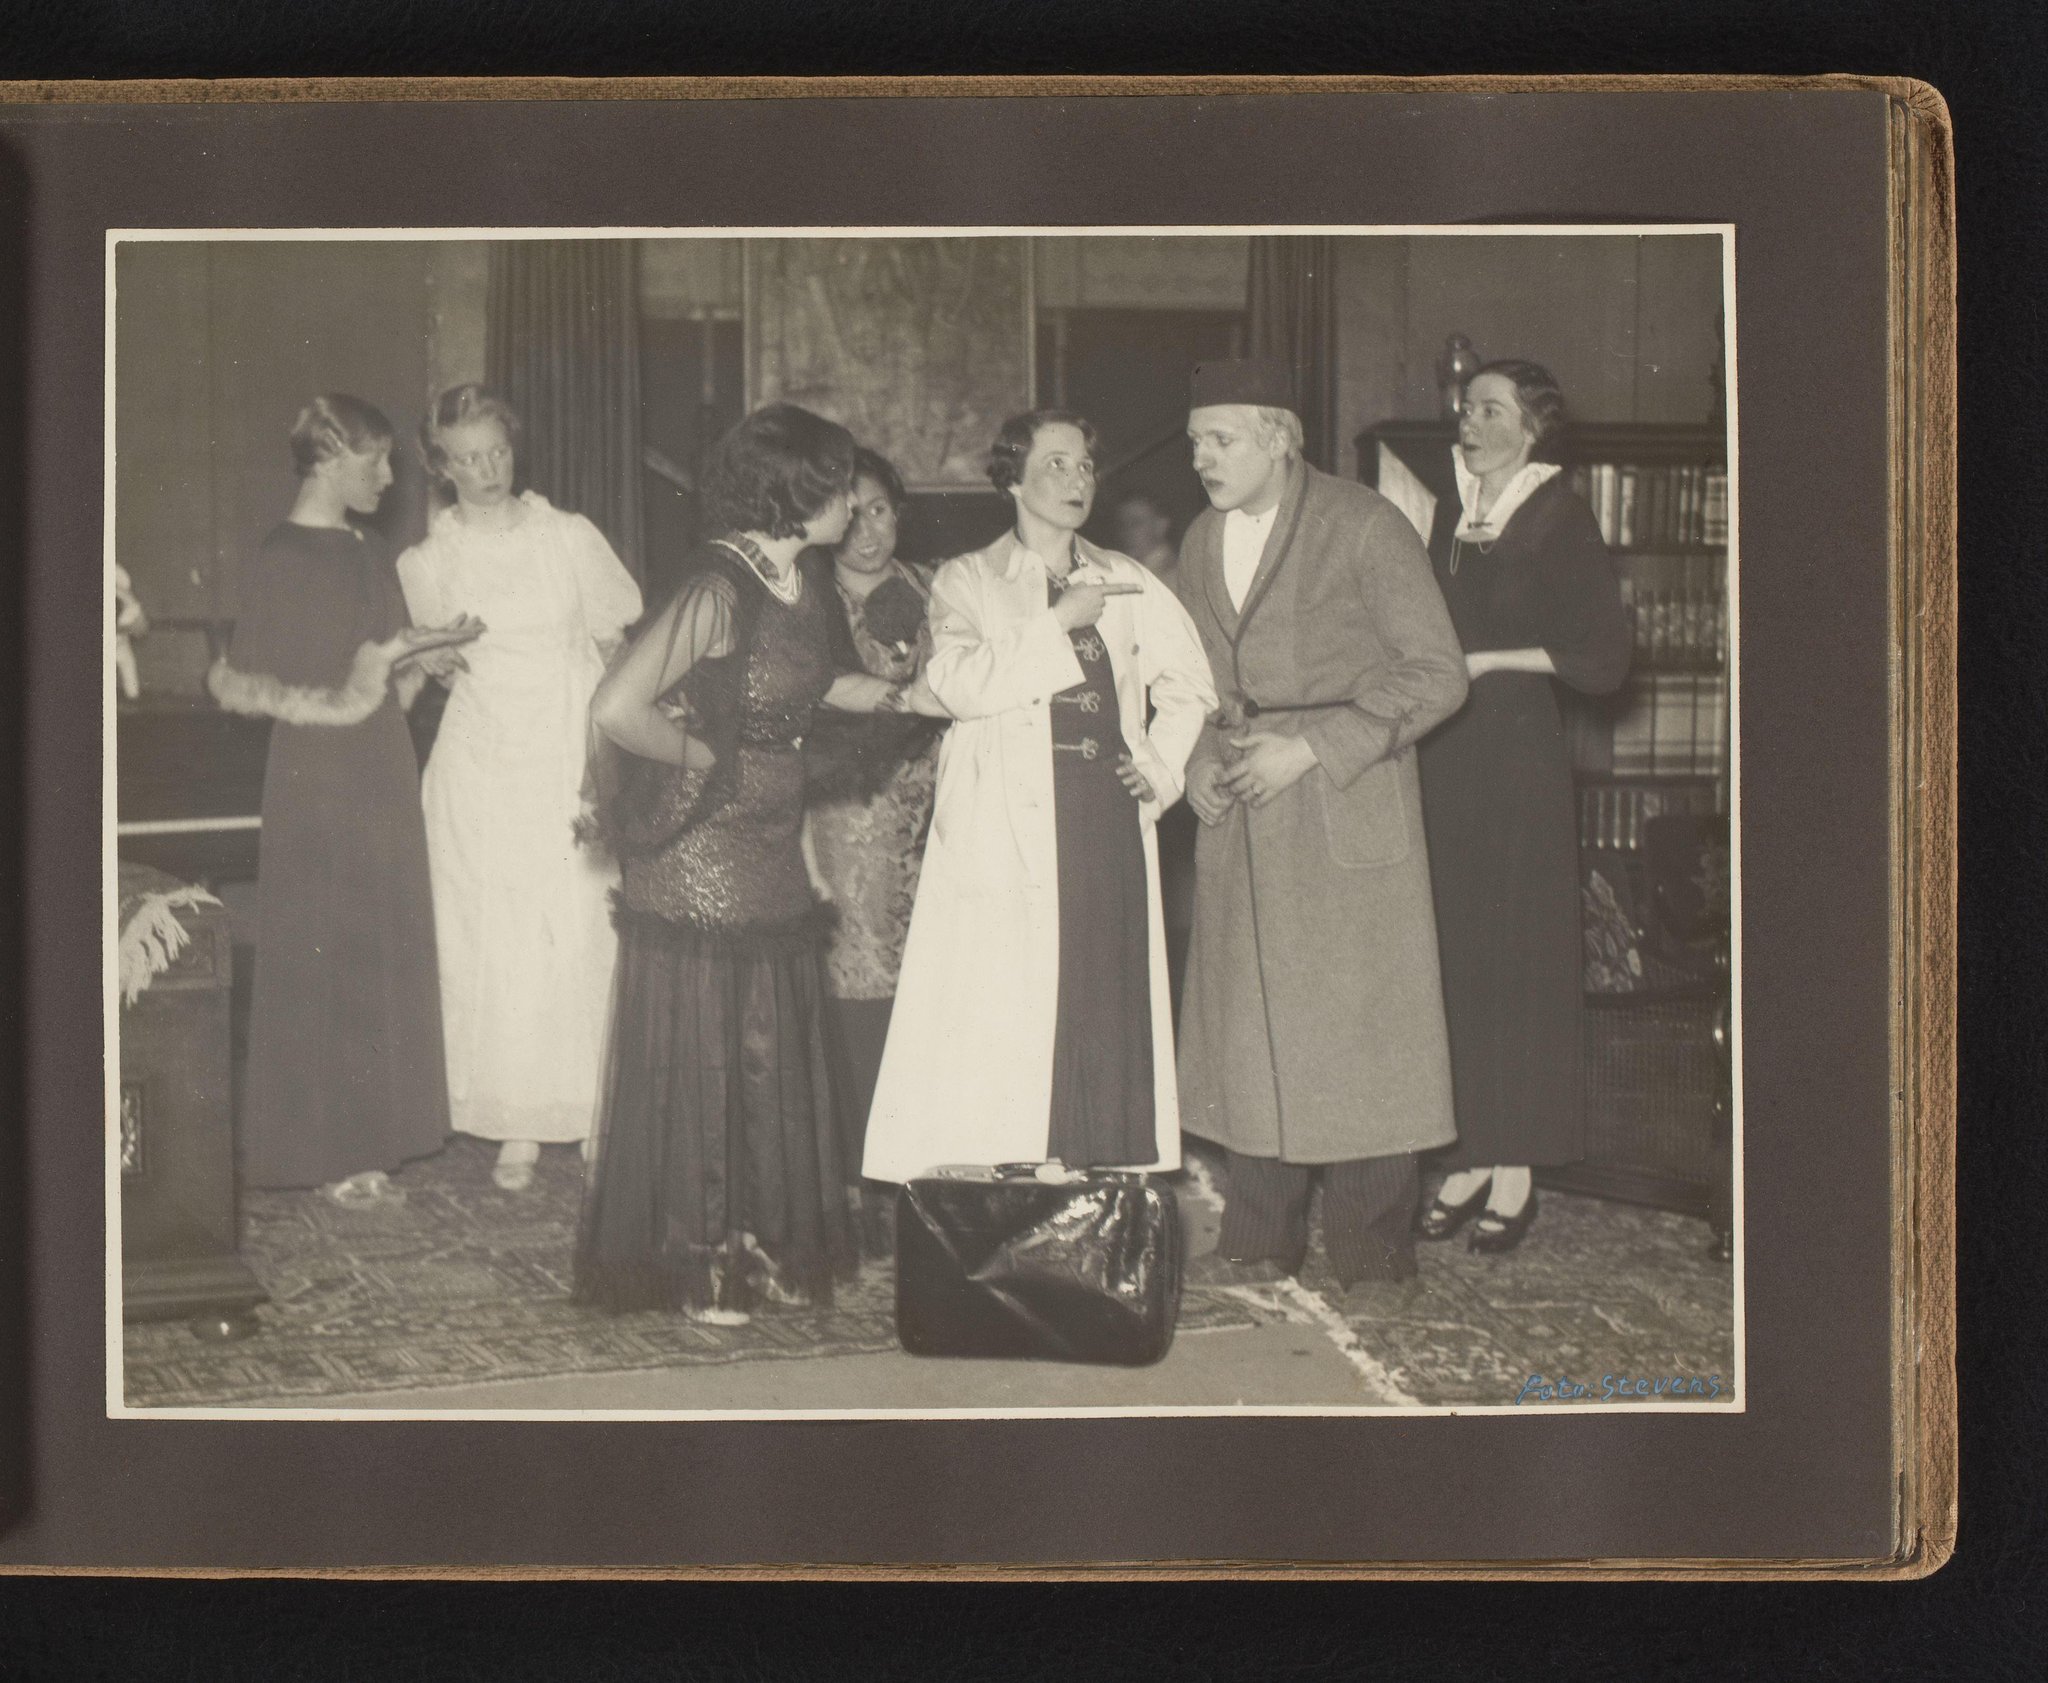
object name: photograph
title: Een scène uit het toneelstuk 'Wat Jonas overkwam'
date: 1936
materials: paper, photographic support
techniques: gelatin silver print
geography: haarlem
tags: theatre, theatrical performance, students' organization, vocational education, e.g.: junior technical school, haarlem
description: Albumblad met een foto van een scène uit de opvoering van het toneelstuk 'Wat Jonas overkwam' op 22 februari 1936. Scène met een groep personen op het toneel. Onderdeel van het fotoalbum 'Jaarfeesten van het Corps M.T.S. te Haarlem'.